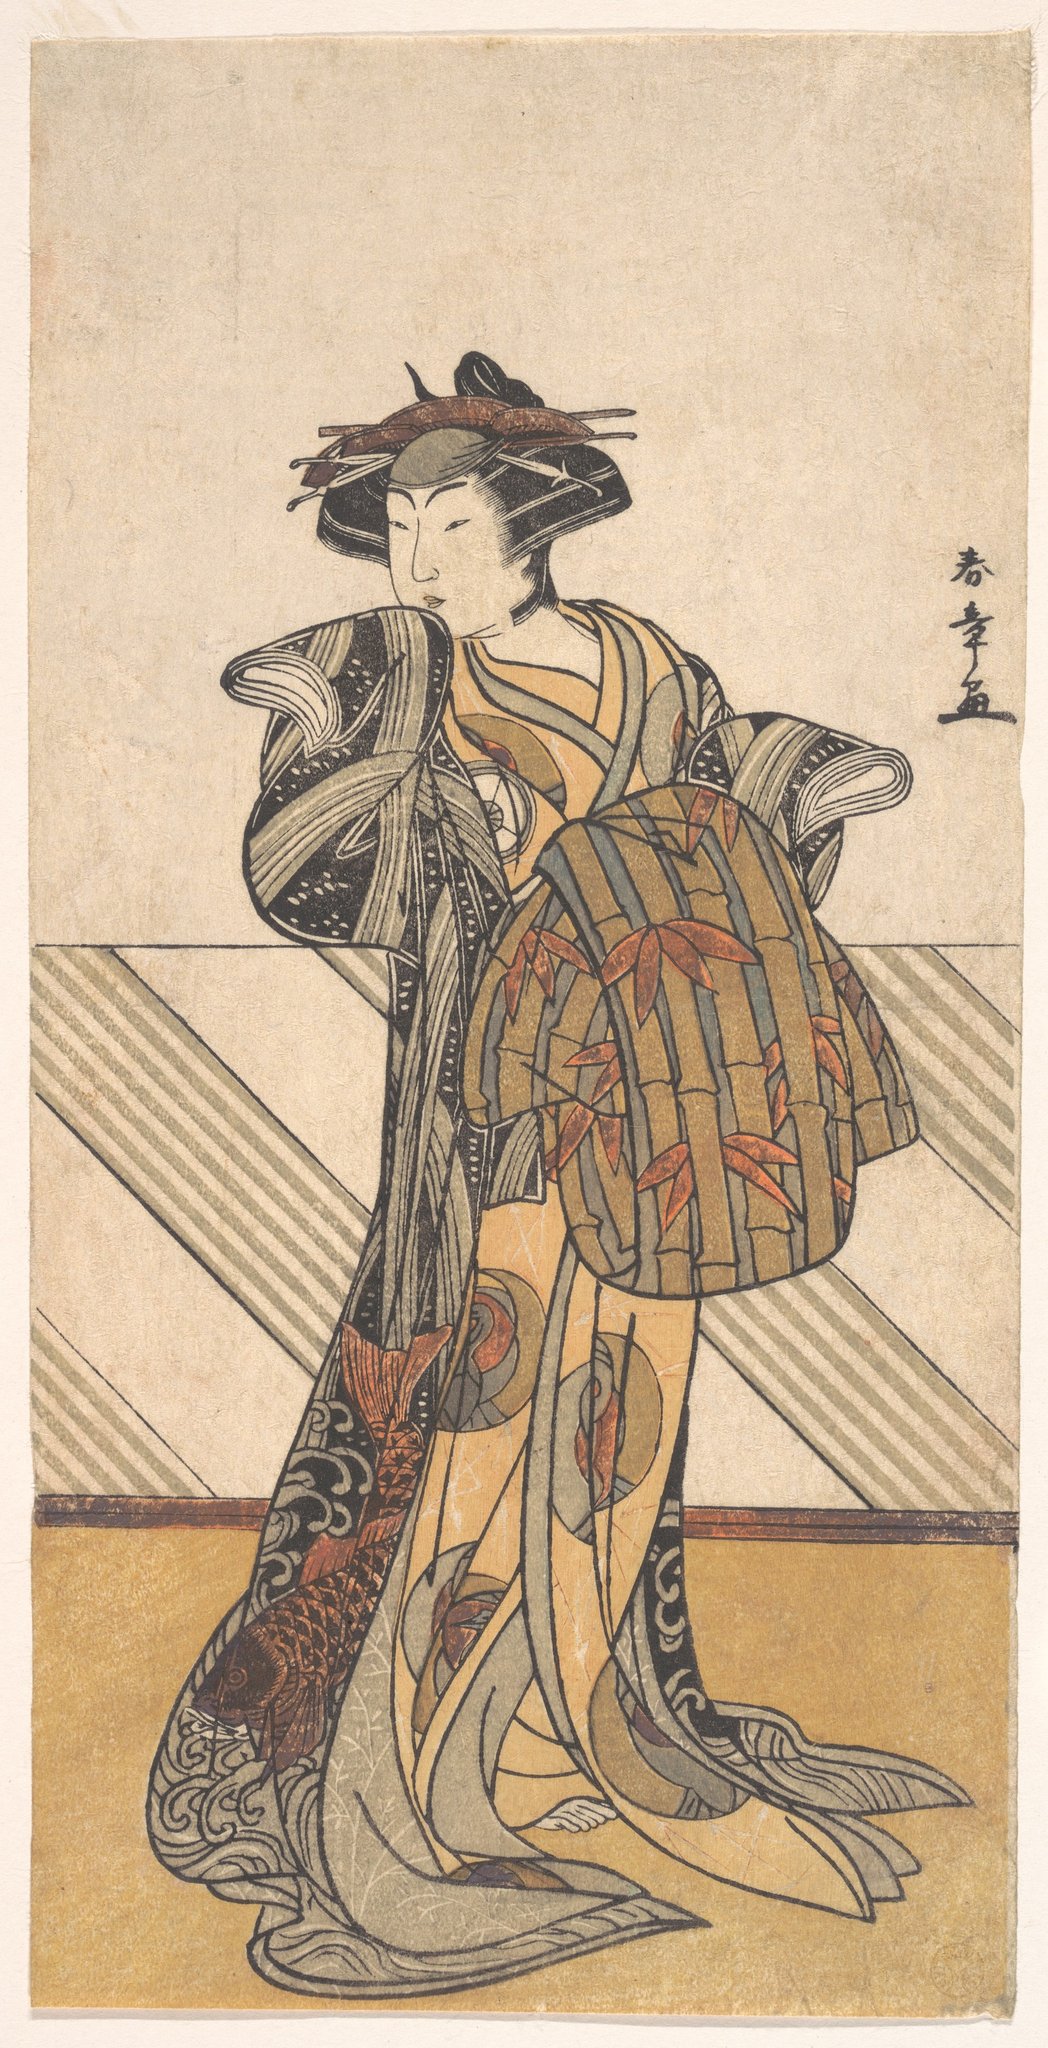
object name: woodblock print nishiki e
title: Kabuki Actor Iwai Hanshirō IV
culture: japanese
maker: katsukawa shunshō 勝川春章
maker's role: artist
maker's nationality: japanese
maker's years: 1726-1792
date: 1778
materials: ink, paper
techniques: nishiki e, woodblock print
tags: actors